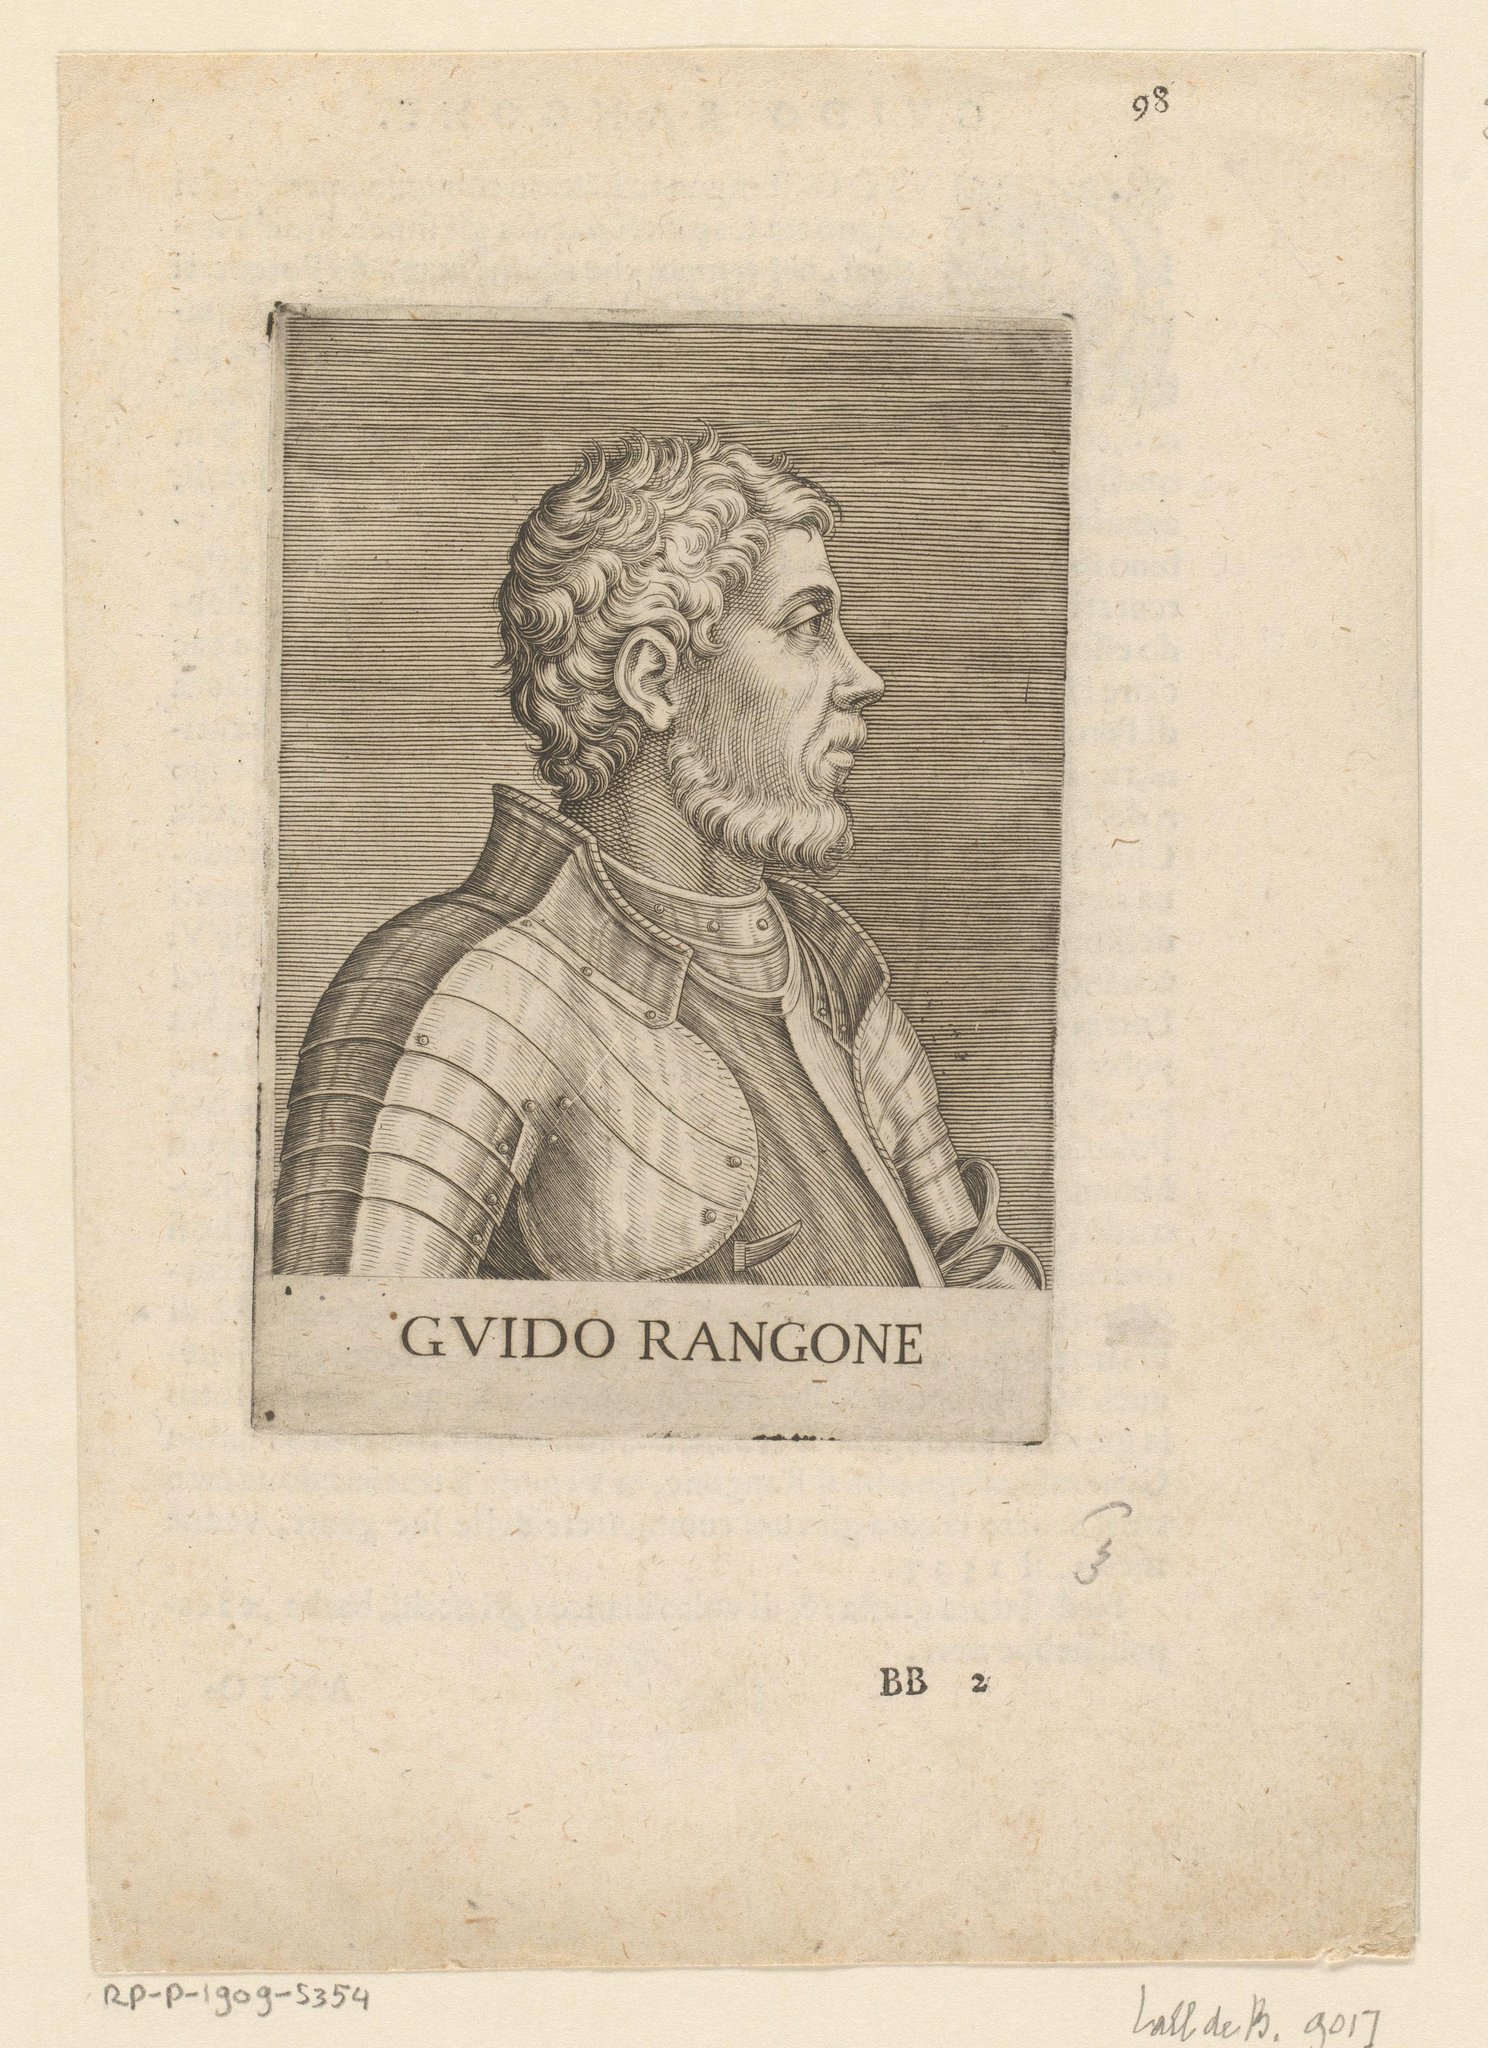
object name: print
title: Guido Rangone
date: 1596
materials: paper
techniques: engraving, letterpress printing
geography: rome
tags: commander-in-chief, general, marshal, historical persons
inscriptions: collector's mark: Lugt 2228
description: Prent uit: Ritratti di cento capitani illustri con li lor Fatti in guerra (…), Rome: Domenico Gigliotti, 1596. Latere staten van prent in ieder geval ook gebruikt in: Ritratti et elogii di capitani Illustri. Rome: Pompilio Totti en Andrea Fei, 1635. En in: Ritratti et elogii di capitani Illustri. Che ne'secoli moderni hanno gloriosamente guerreggiato. Rome: Filippo de'Rossi en Vitale Mascardi, 1646.